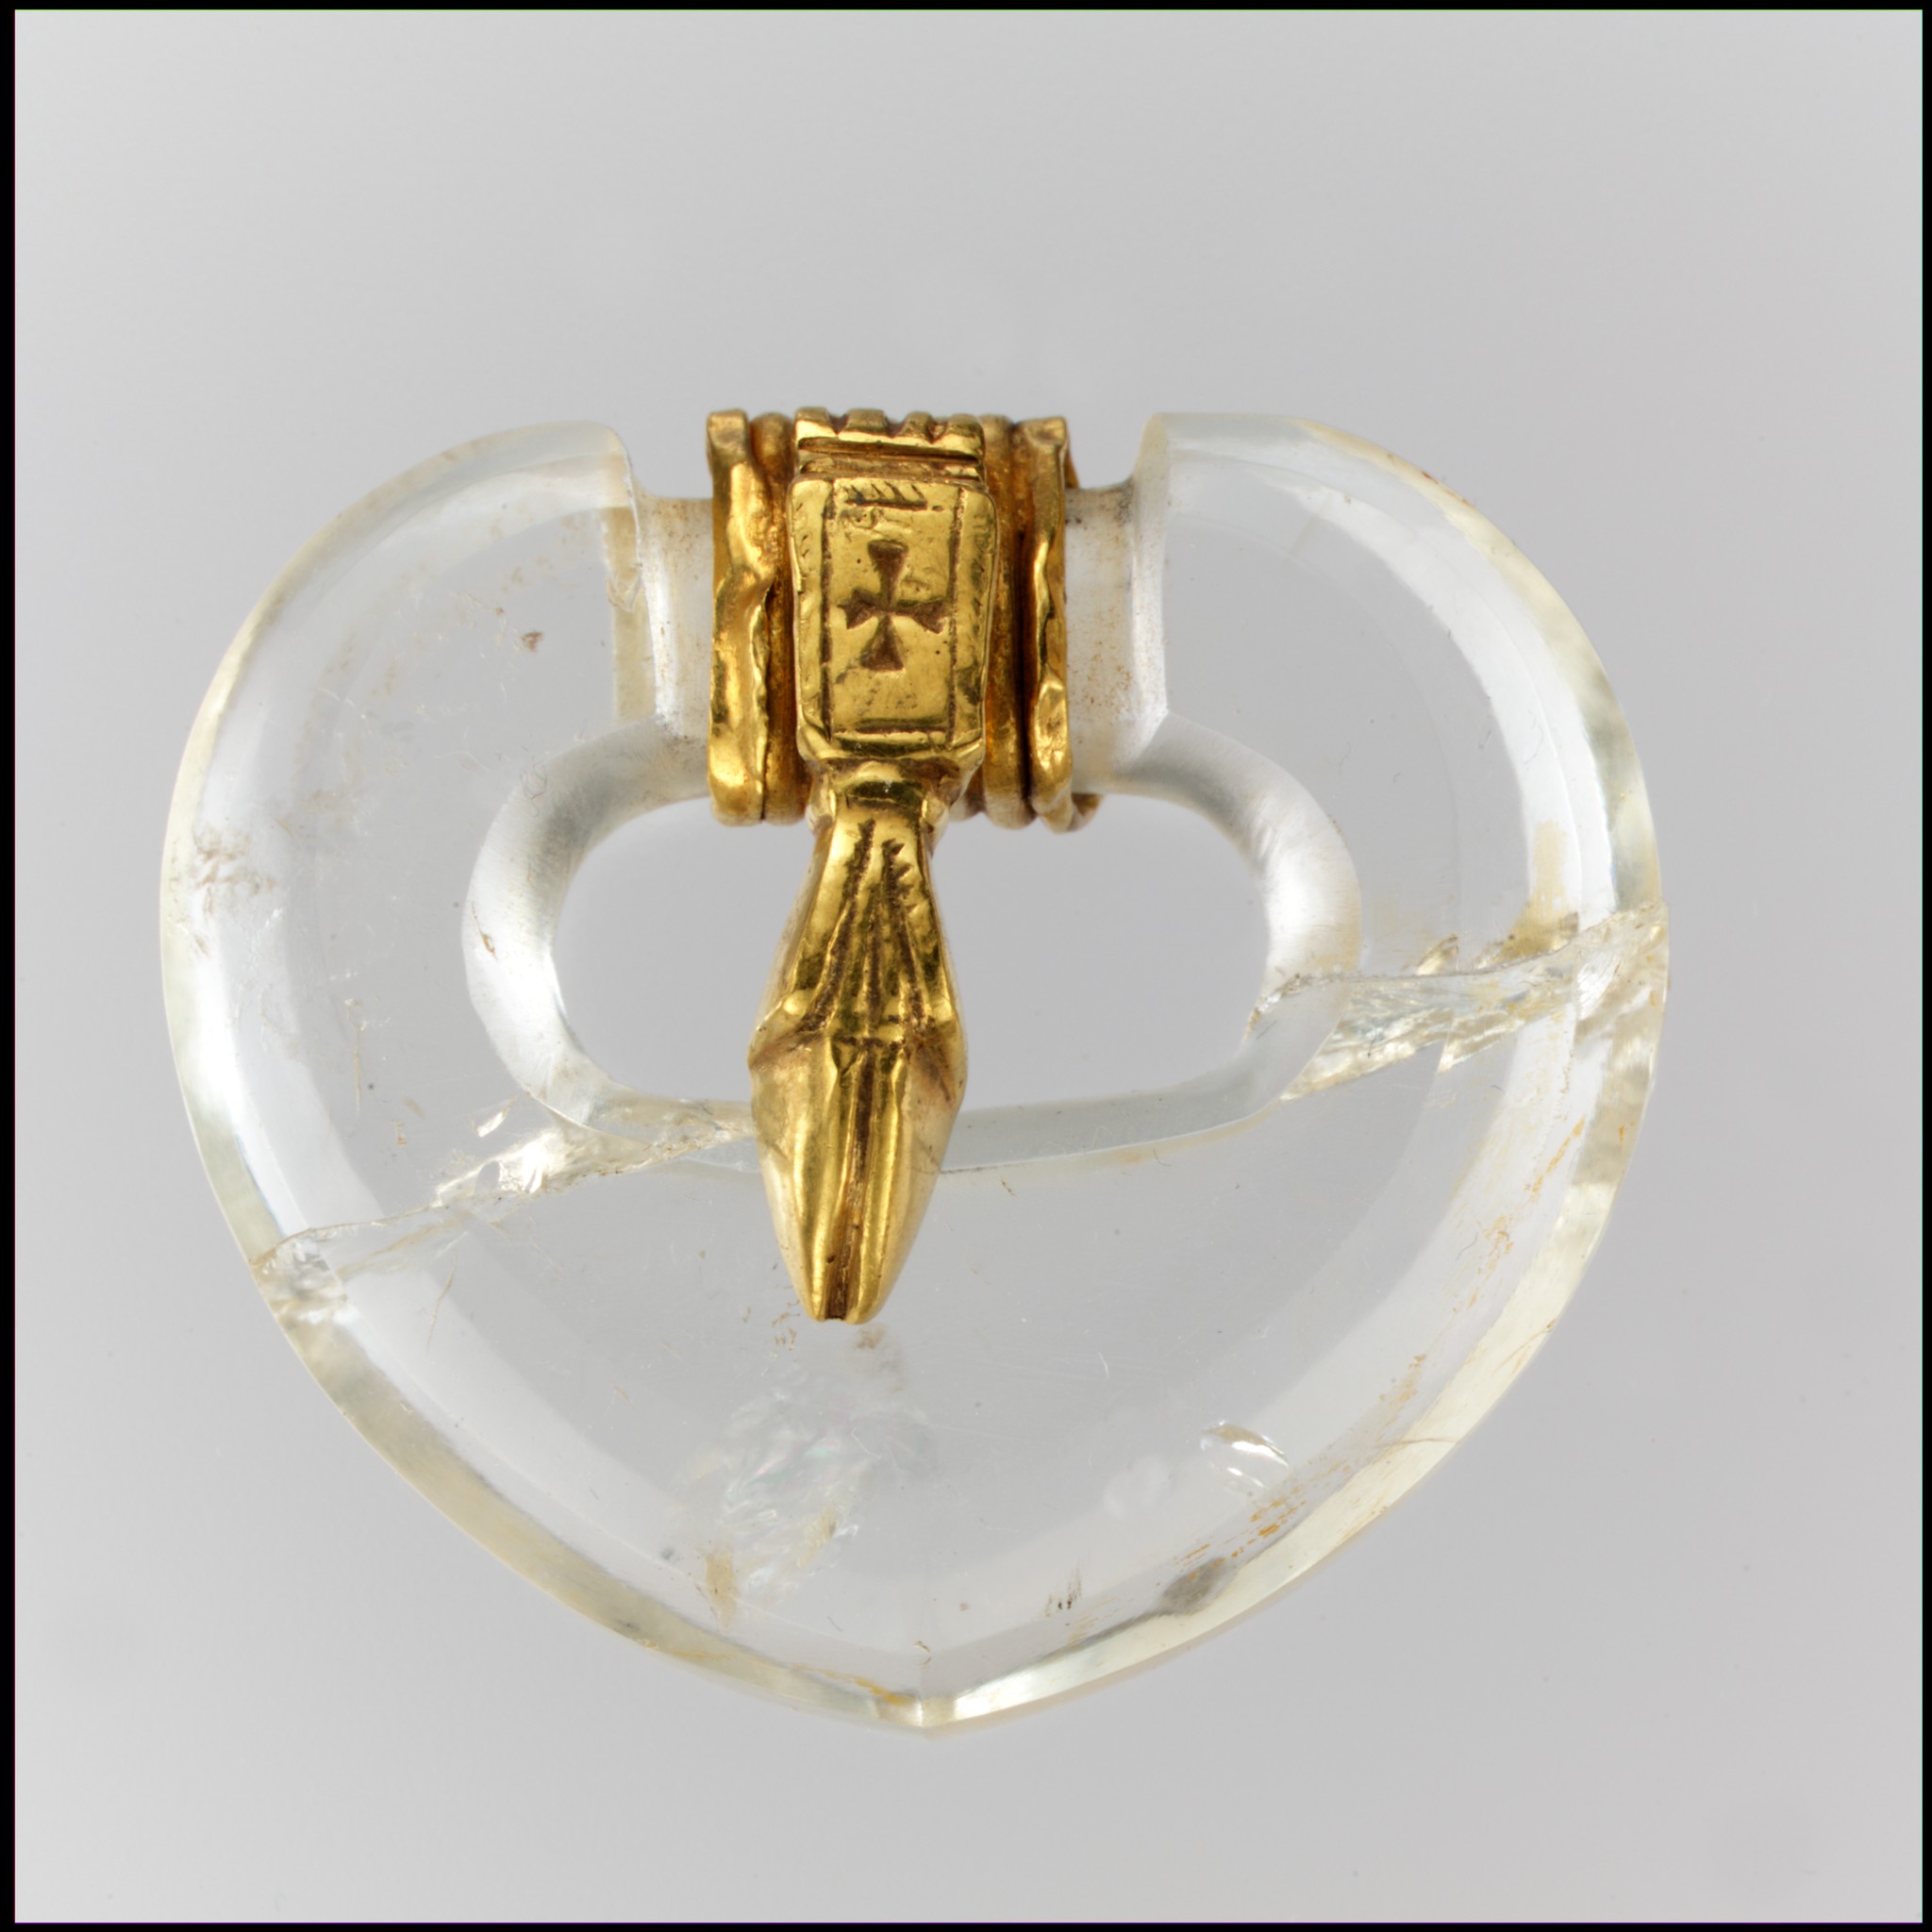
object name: belt buckle and tongue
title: Rock Crystal Belt Buckle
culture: german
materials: gold foil, quartz